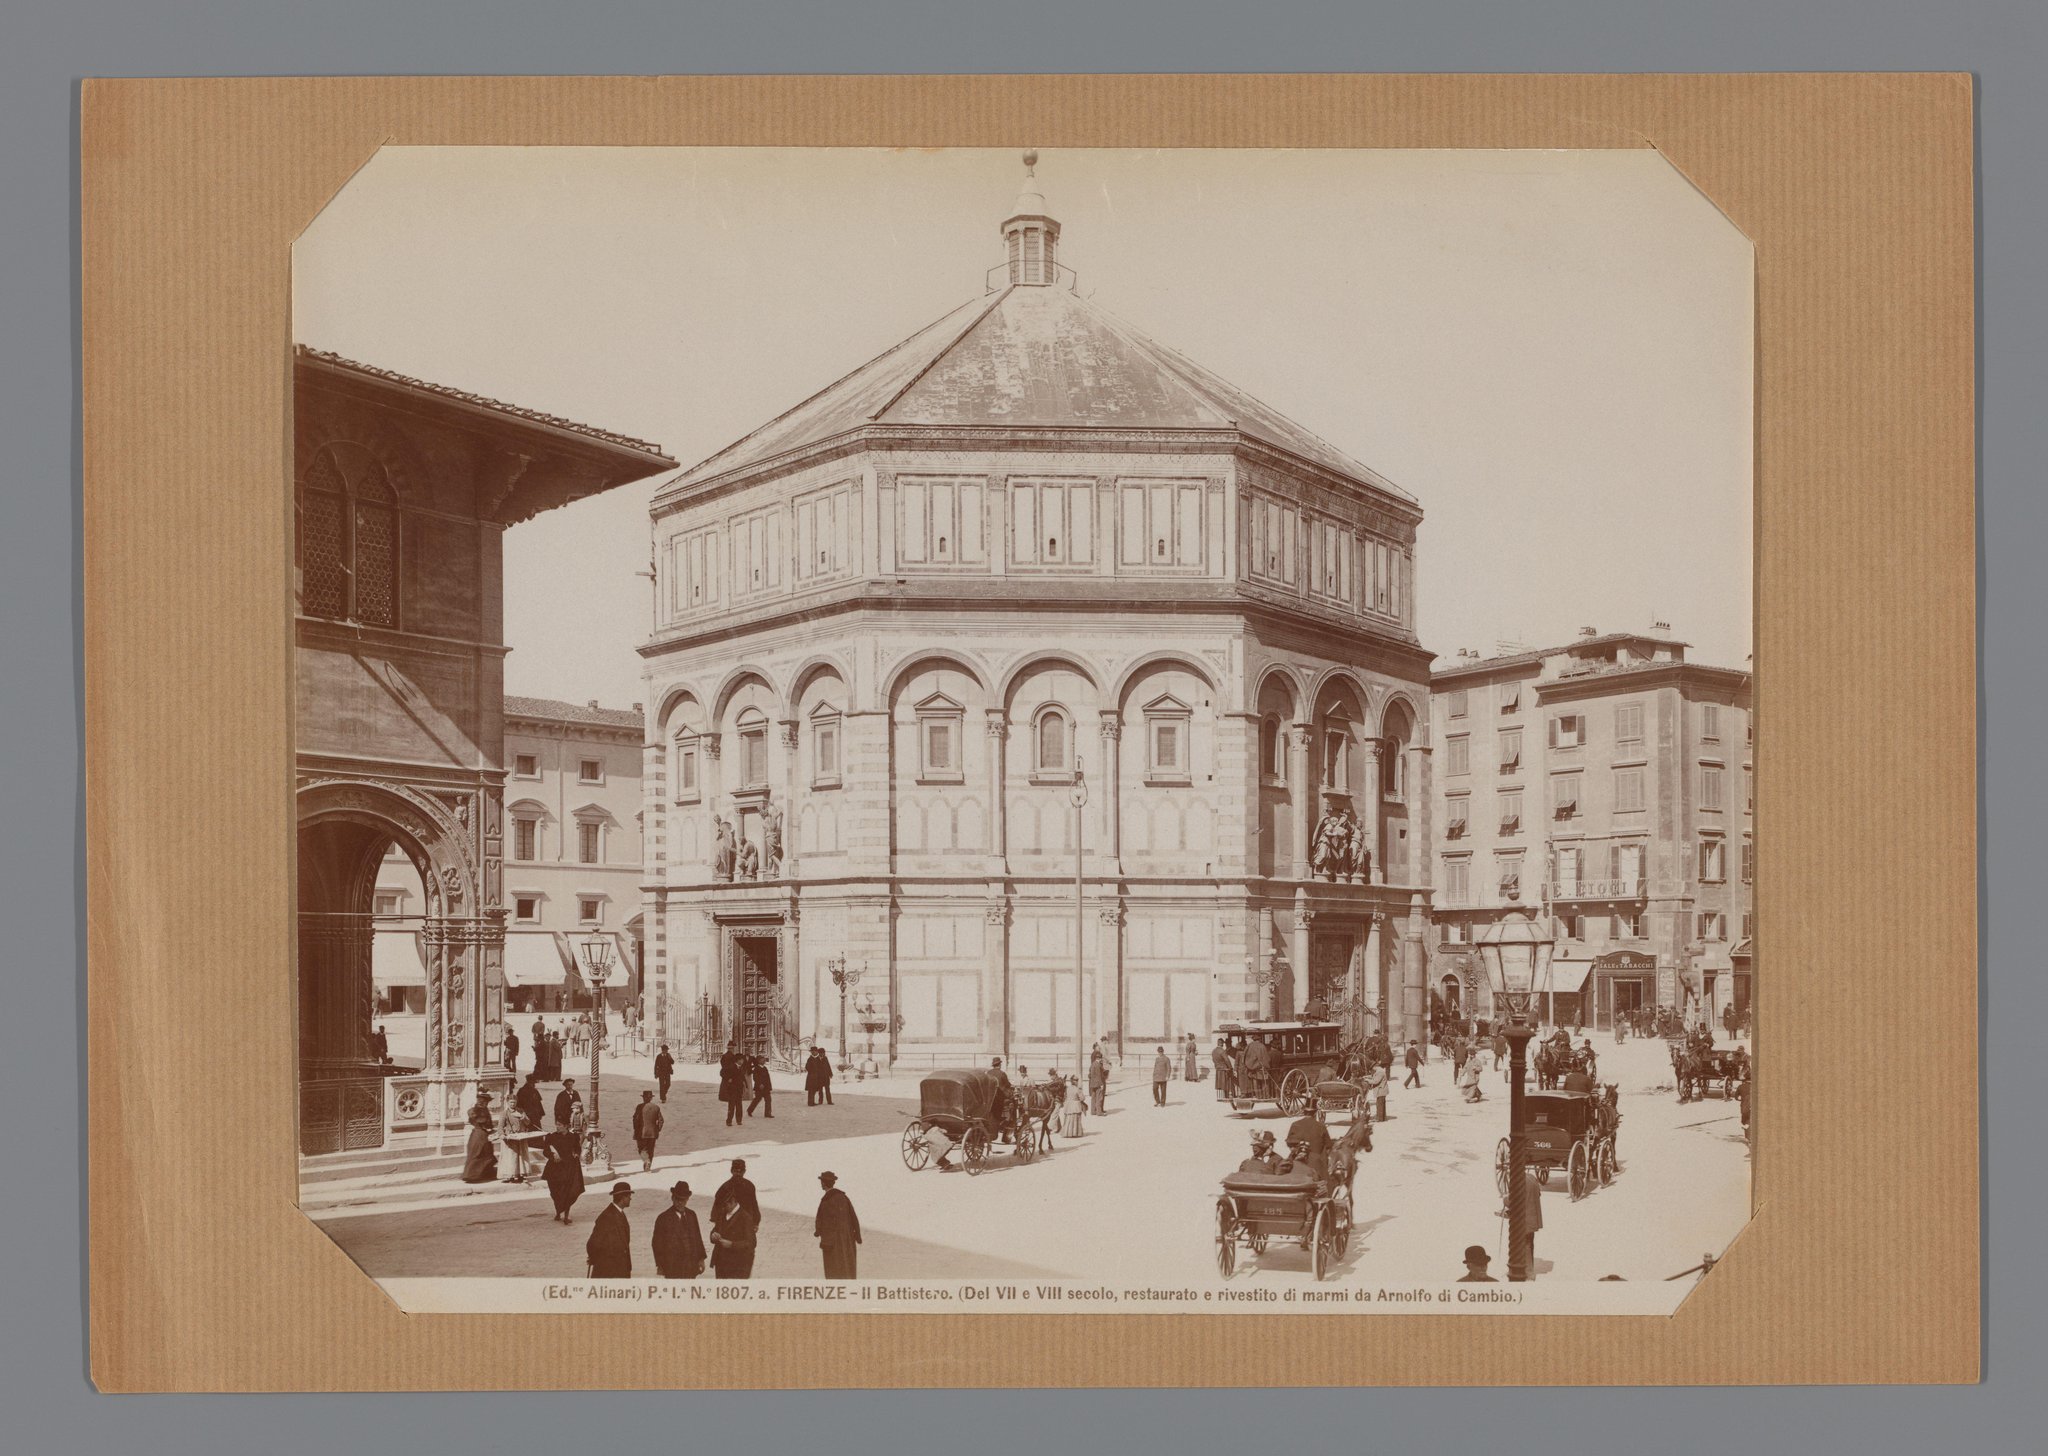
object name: photograph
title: Italië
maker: Anonymous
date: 1880-1910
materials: photographic support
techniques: albumen print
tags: italy